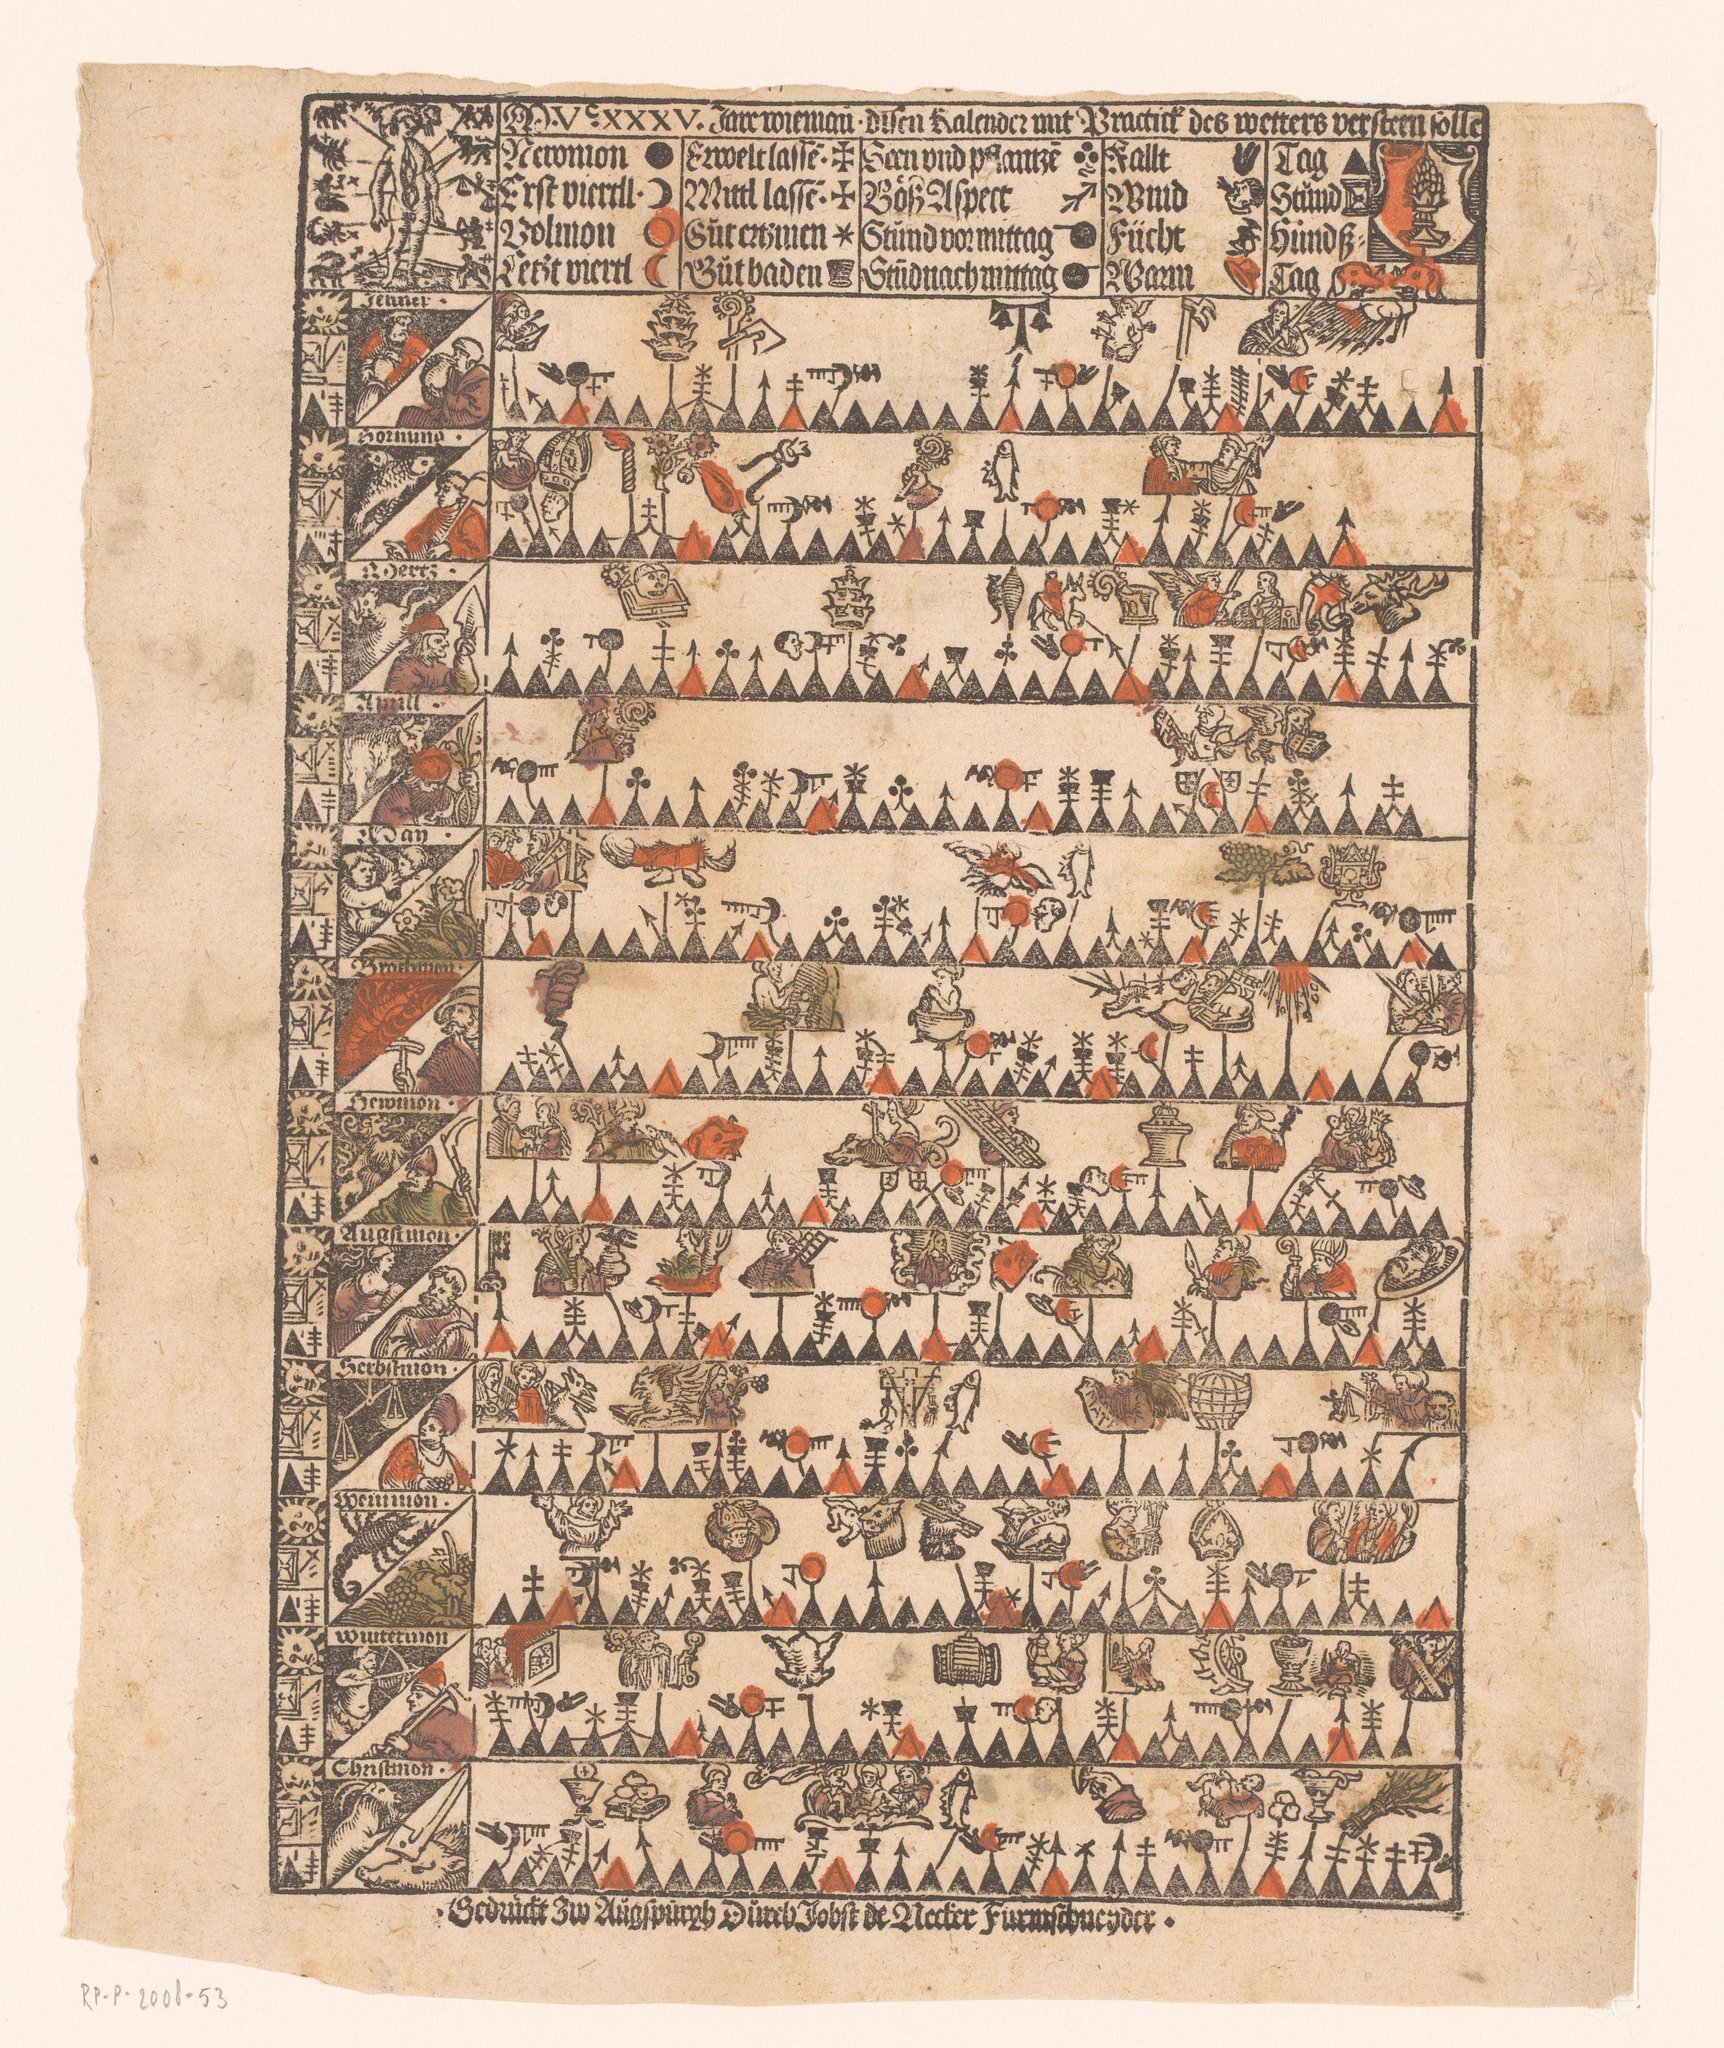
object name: print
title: Jare wieman disen Kalender mit Practick des Wetters versteen solle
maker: jost de negker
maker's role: print maker, printer, publisher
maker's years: 1485-1544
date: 1535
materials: paper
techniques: woodcut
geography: augsburg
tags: calendar of ecclesiastical feasts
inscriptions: date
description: Kalender voor het hele jaar met de tekens van de dierenriem, de maanstanden, de zon- en feestdagen, gunstige dagen voor medische handelingen, weersgesteldheden en allerlei andere zaken door middel van symbolen en kleine afbeeldingen.